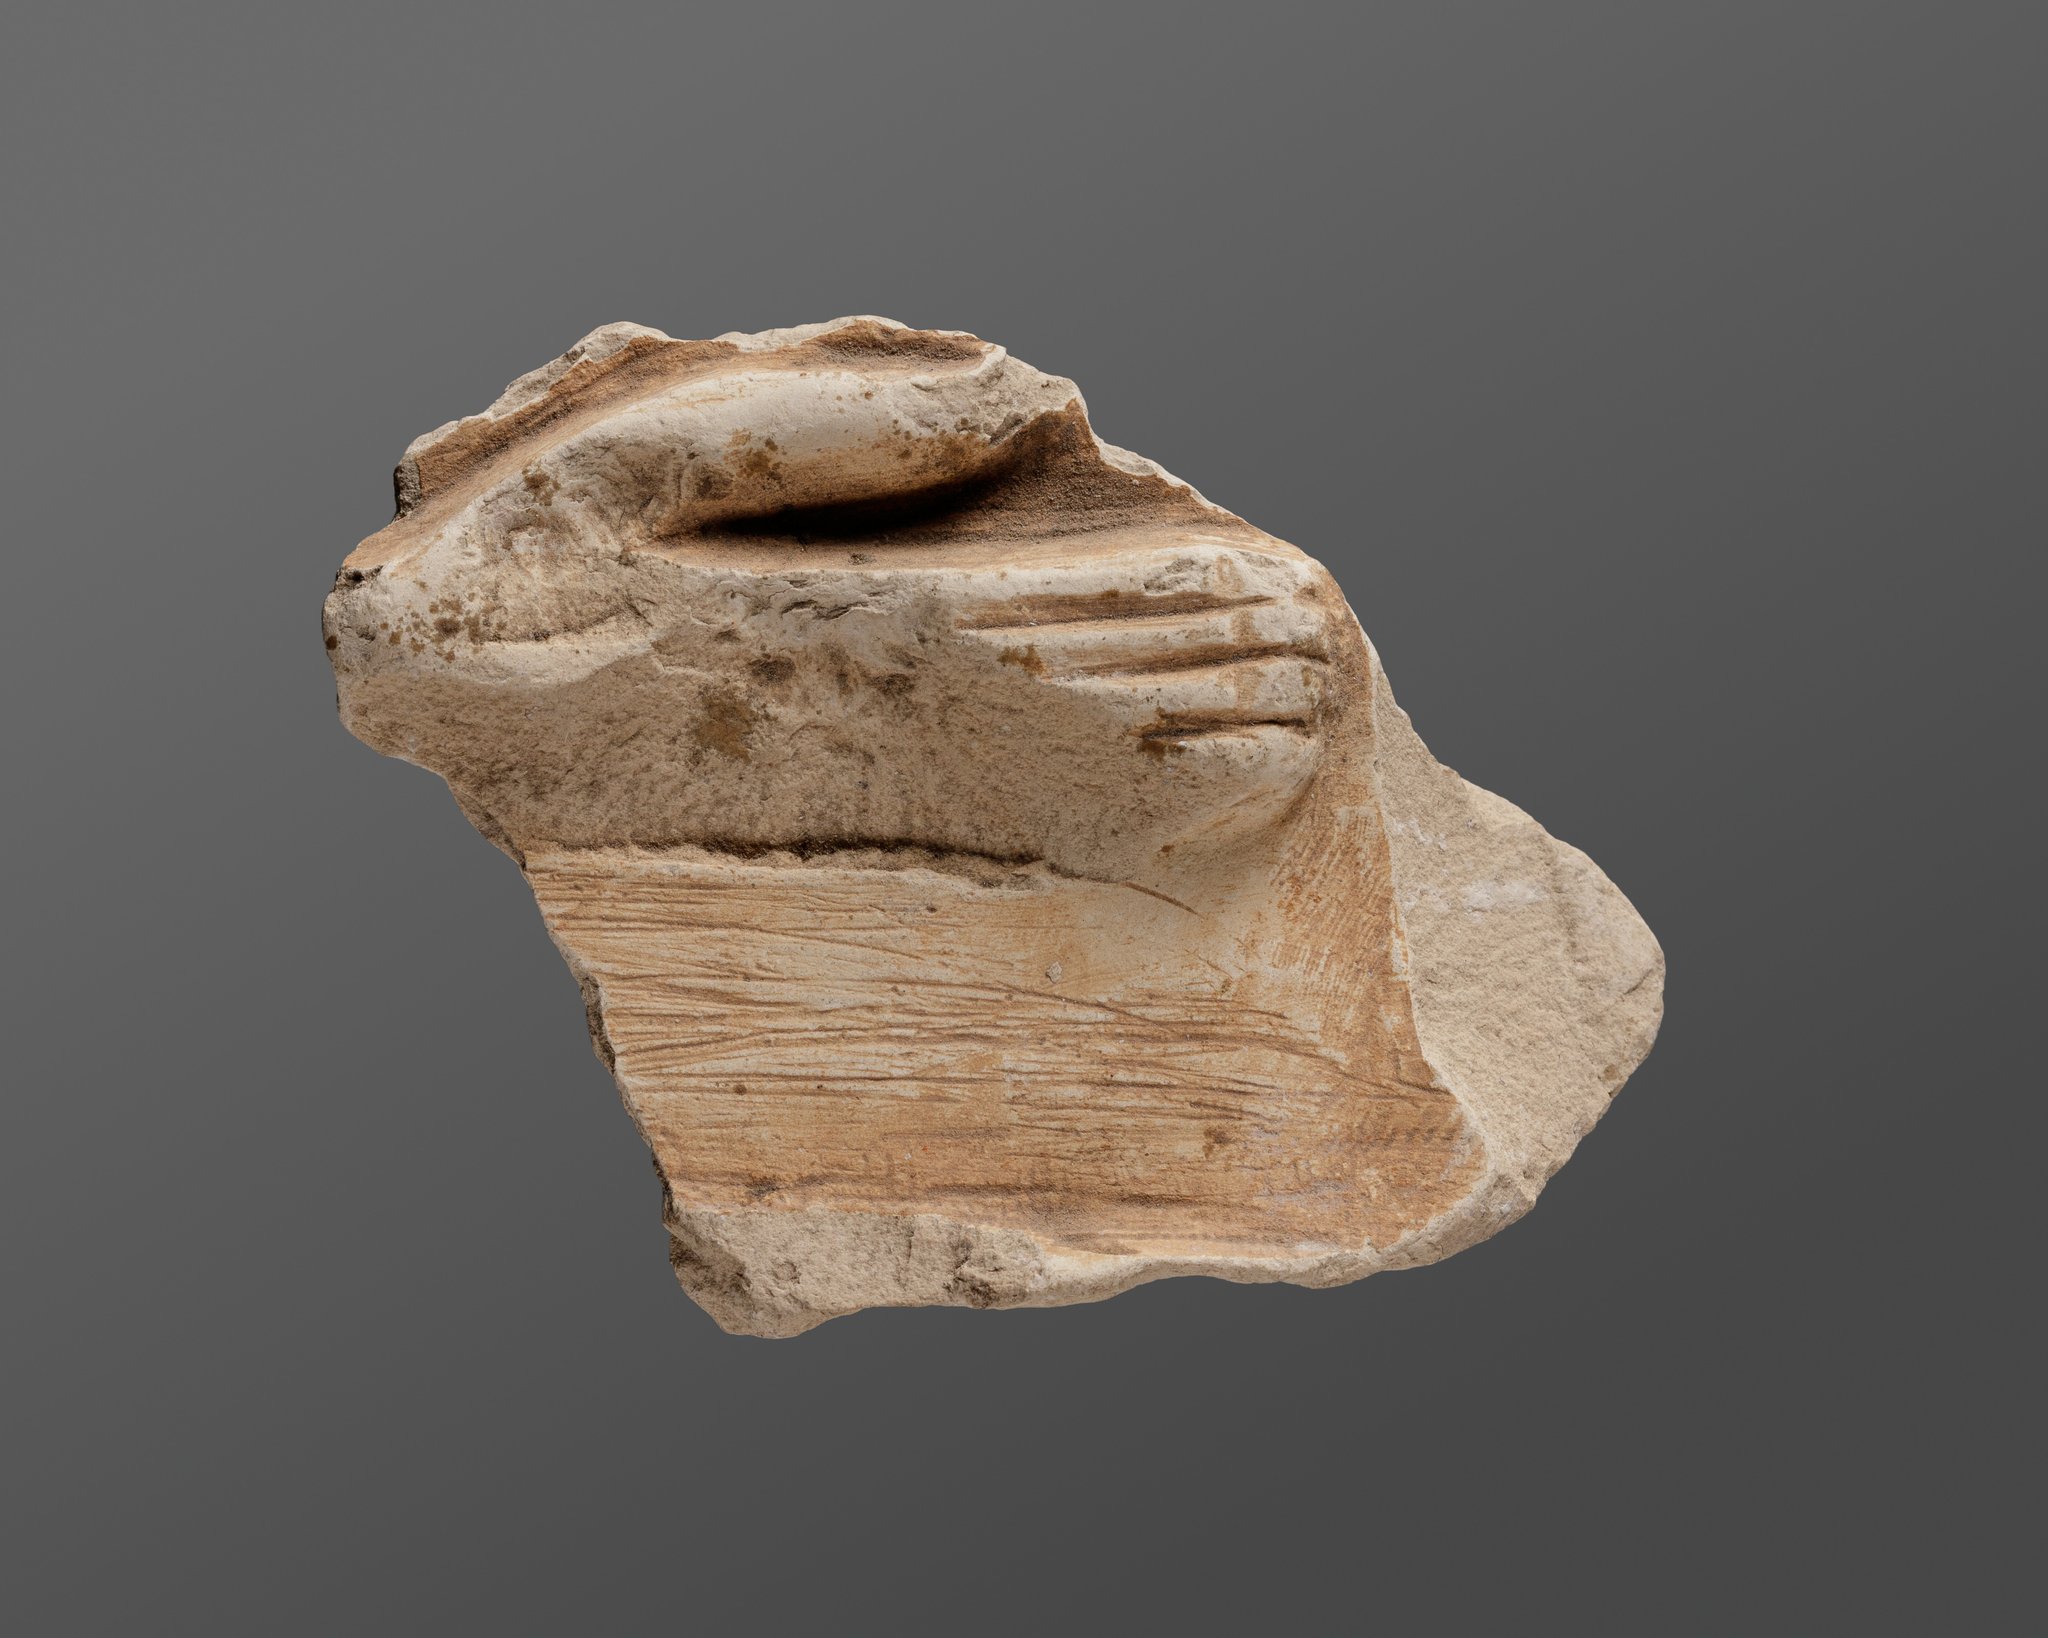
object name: relief fragment 41, tomb of mereri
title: Relief fragment possibly from the tomb of Mereri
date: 2100-2090 BCE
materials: limestone